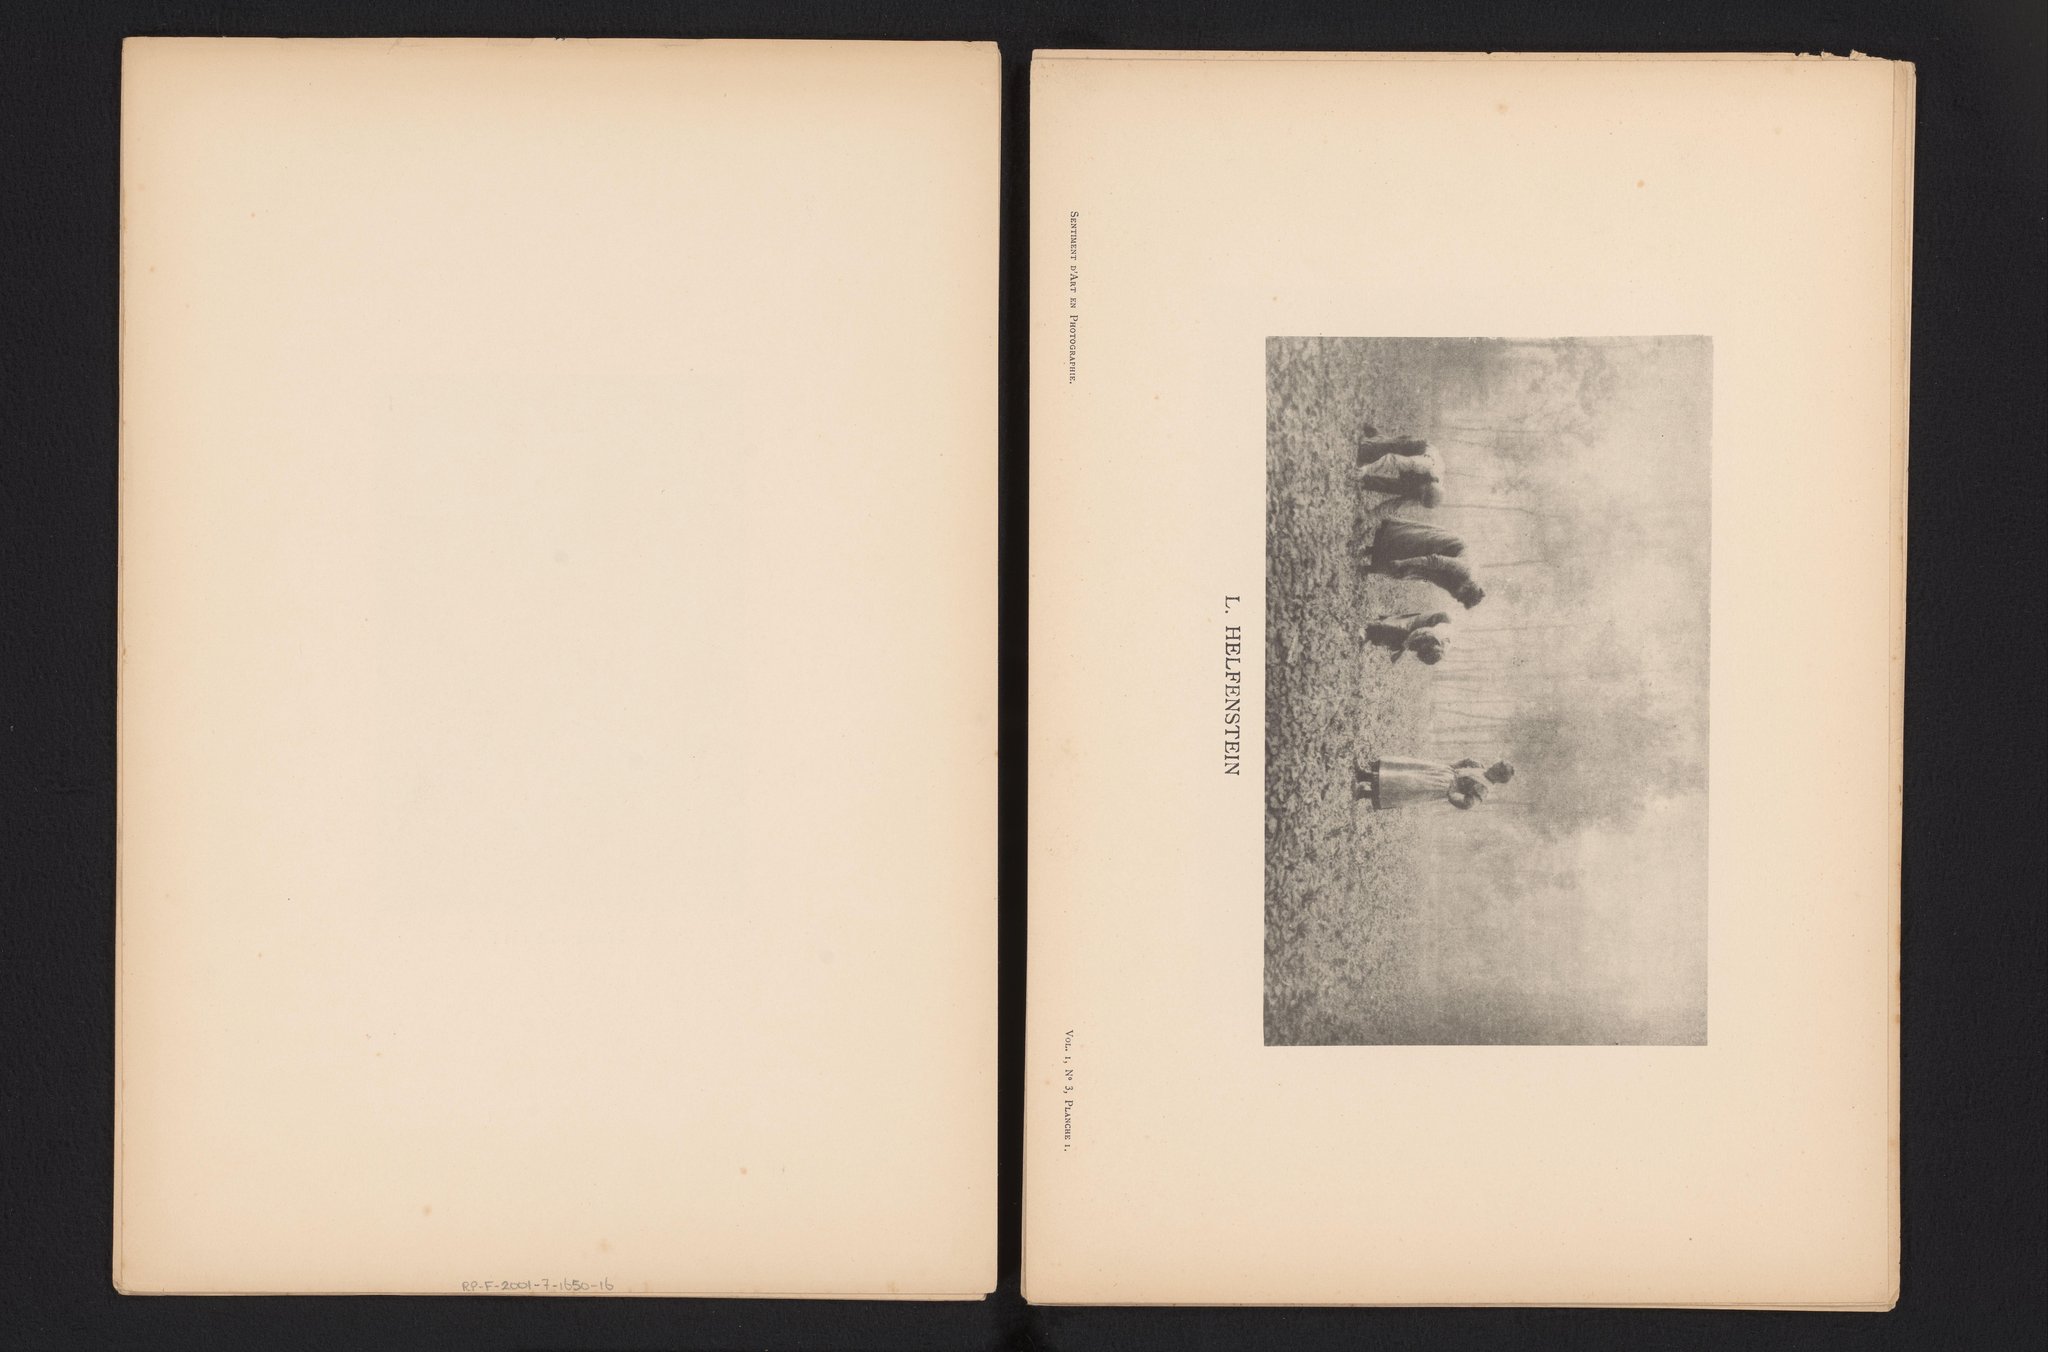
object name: photomechanical print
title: Sentiment d'Art en Photographie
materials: paper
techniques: photograph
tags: farmers - aa - female farmer, farmer's wife, agriculture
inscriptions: number: ‘Vol. 1, No 3, Planche 1.’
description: Deze prent maakt deel uit van 8 omslagen met 22 tekstbladen en 89 prenten op losse bladen in en tussen de omslagen.